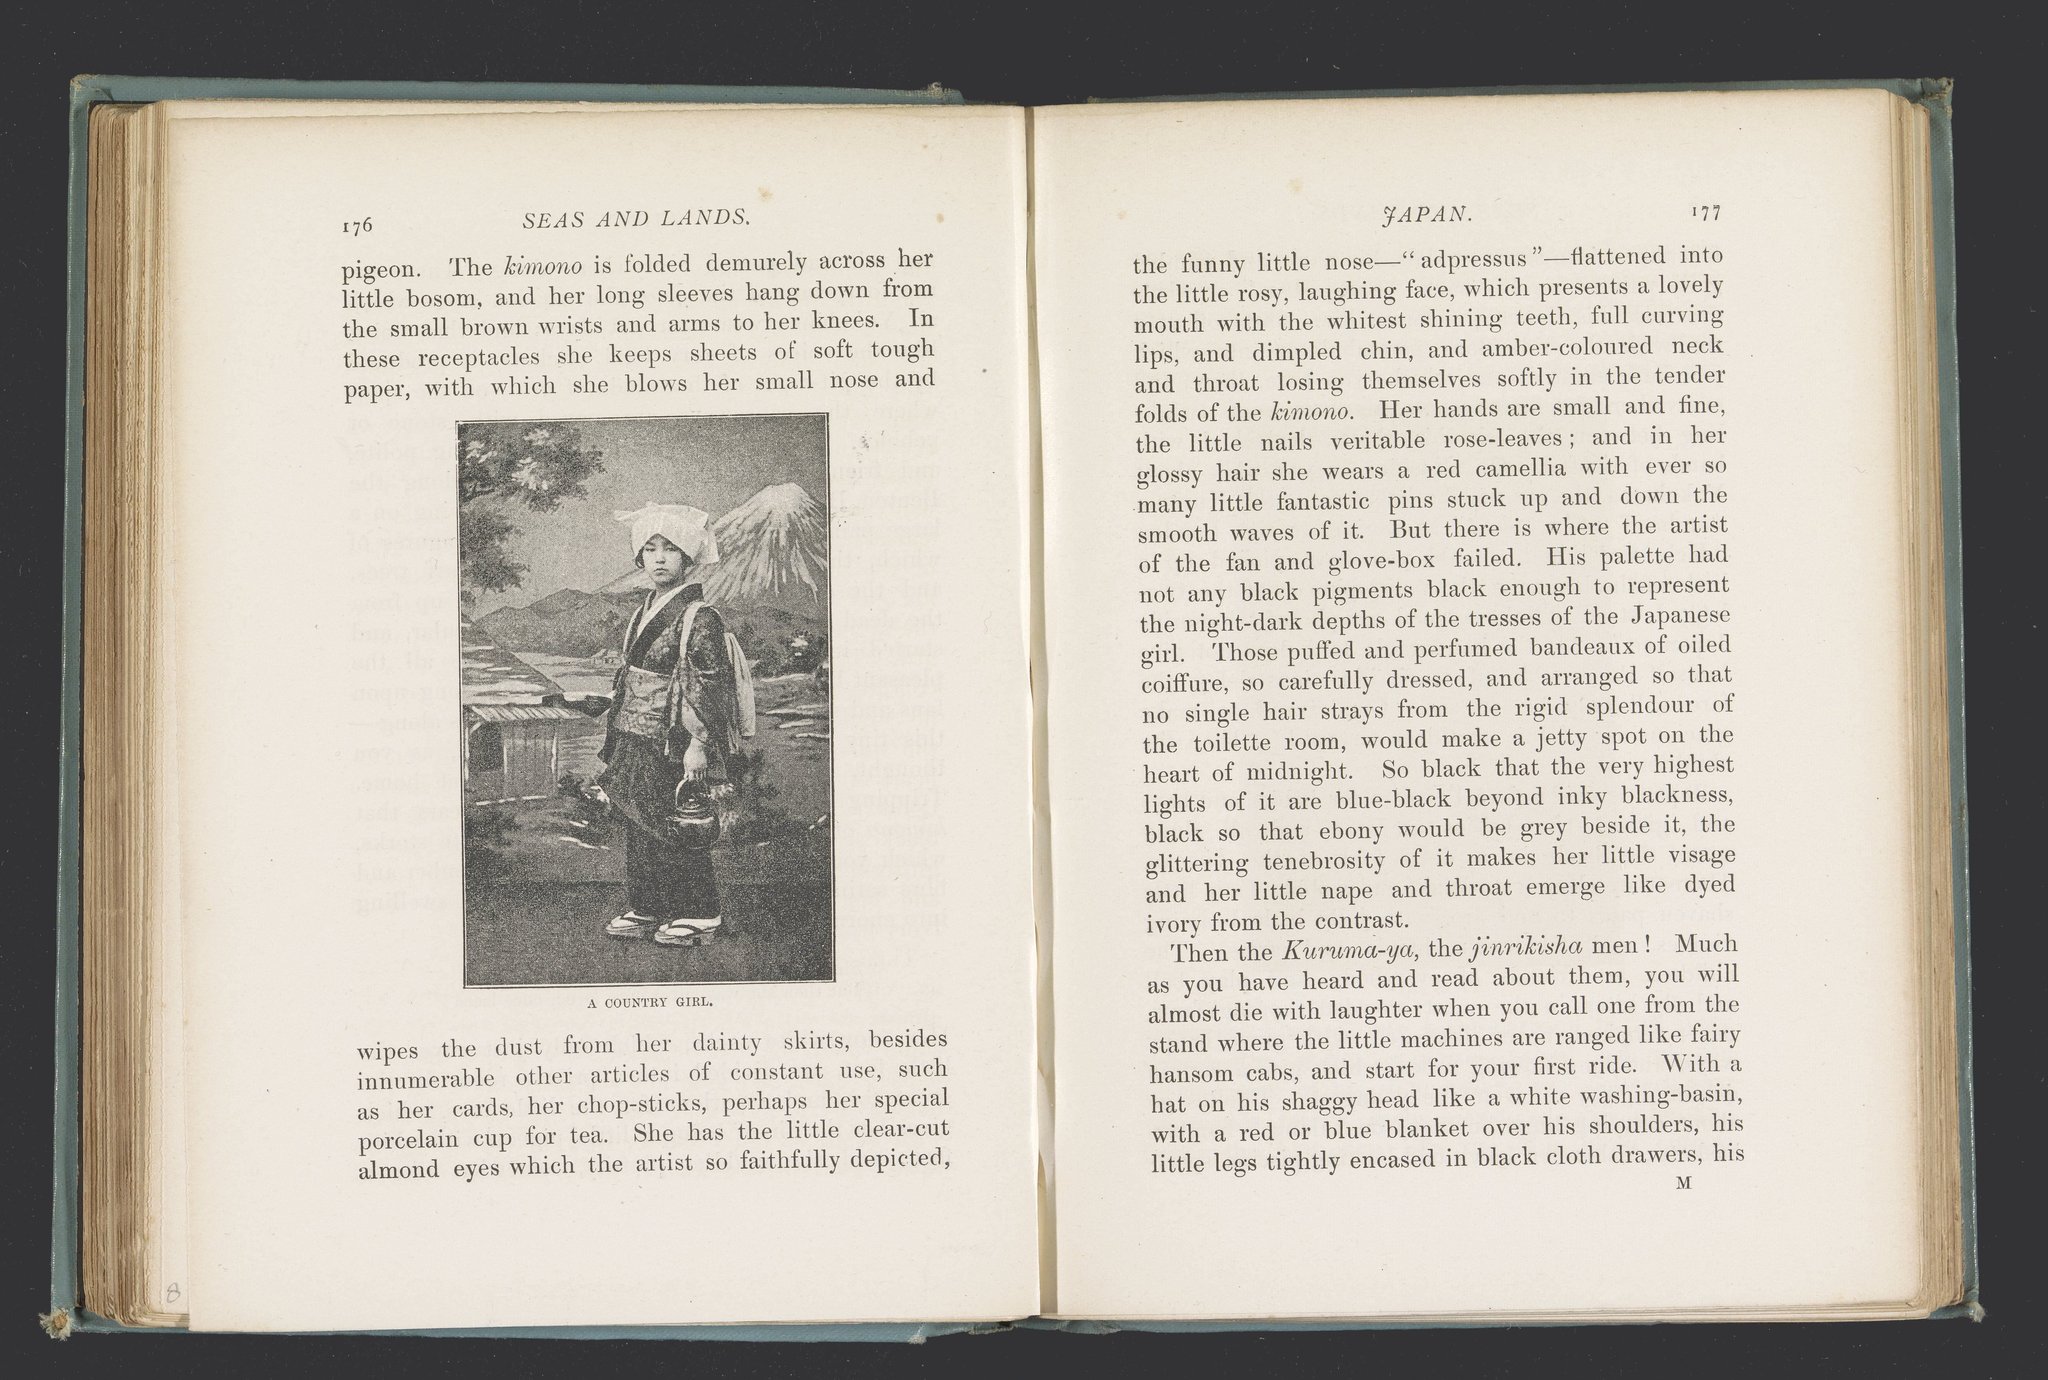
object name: page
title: A country girl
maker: Anonymous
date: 1882-1892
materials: paper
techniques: autotype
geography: japan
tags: adult woman, studio requisites ~ photographer, folk costume, regional costume